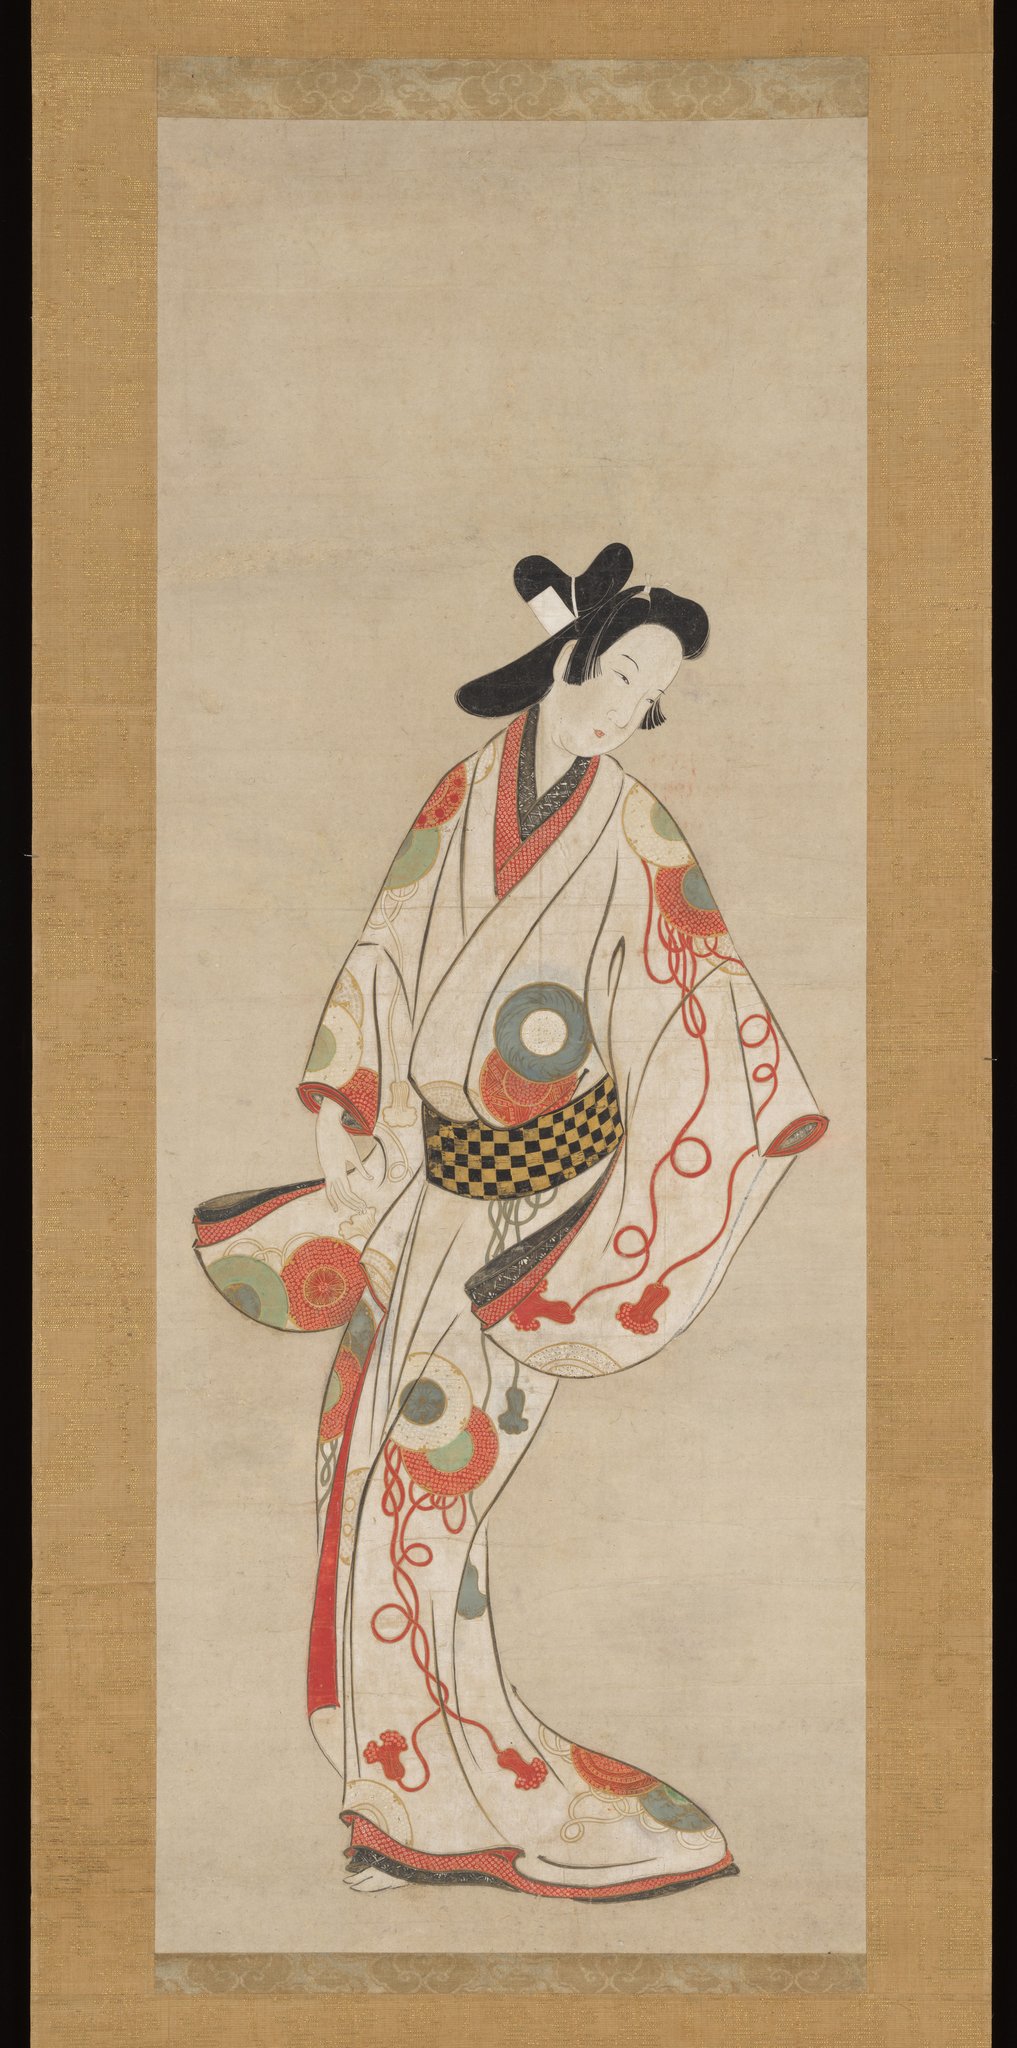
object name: hanging scroll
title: Wakashu (Male Youth)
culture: japanese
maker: unidentified artist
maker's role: artist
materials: paper